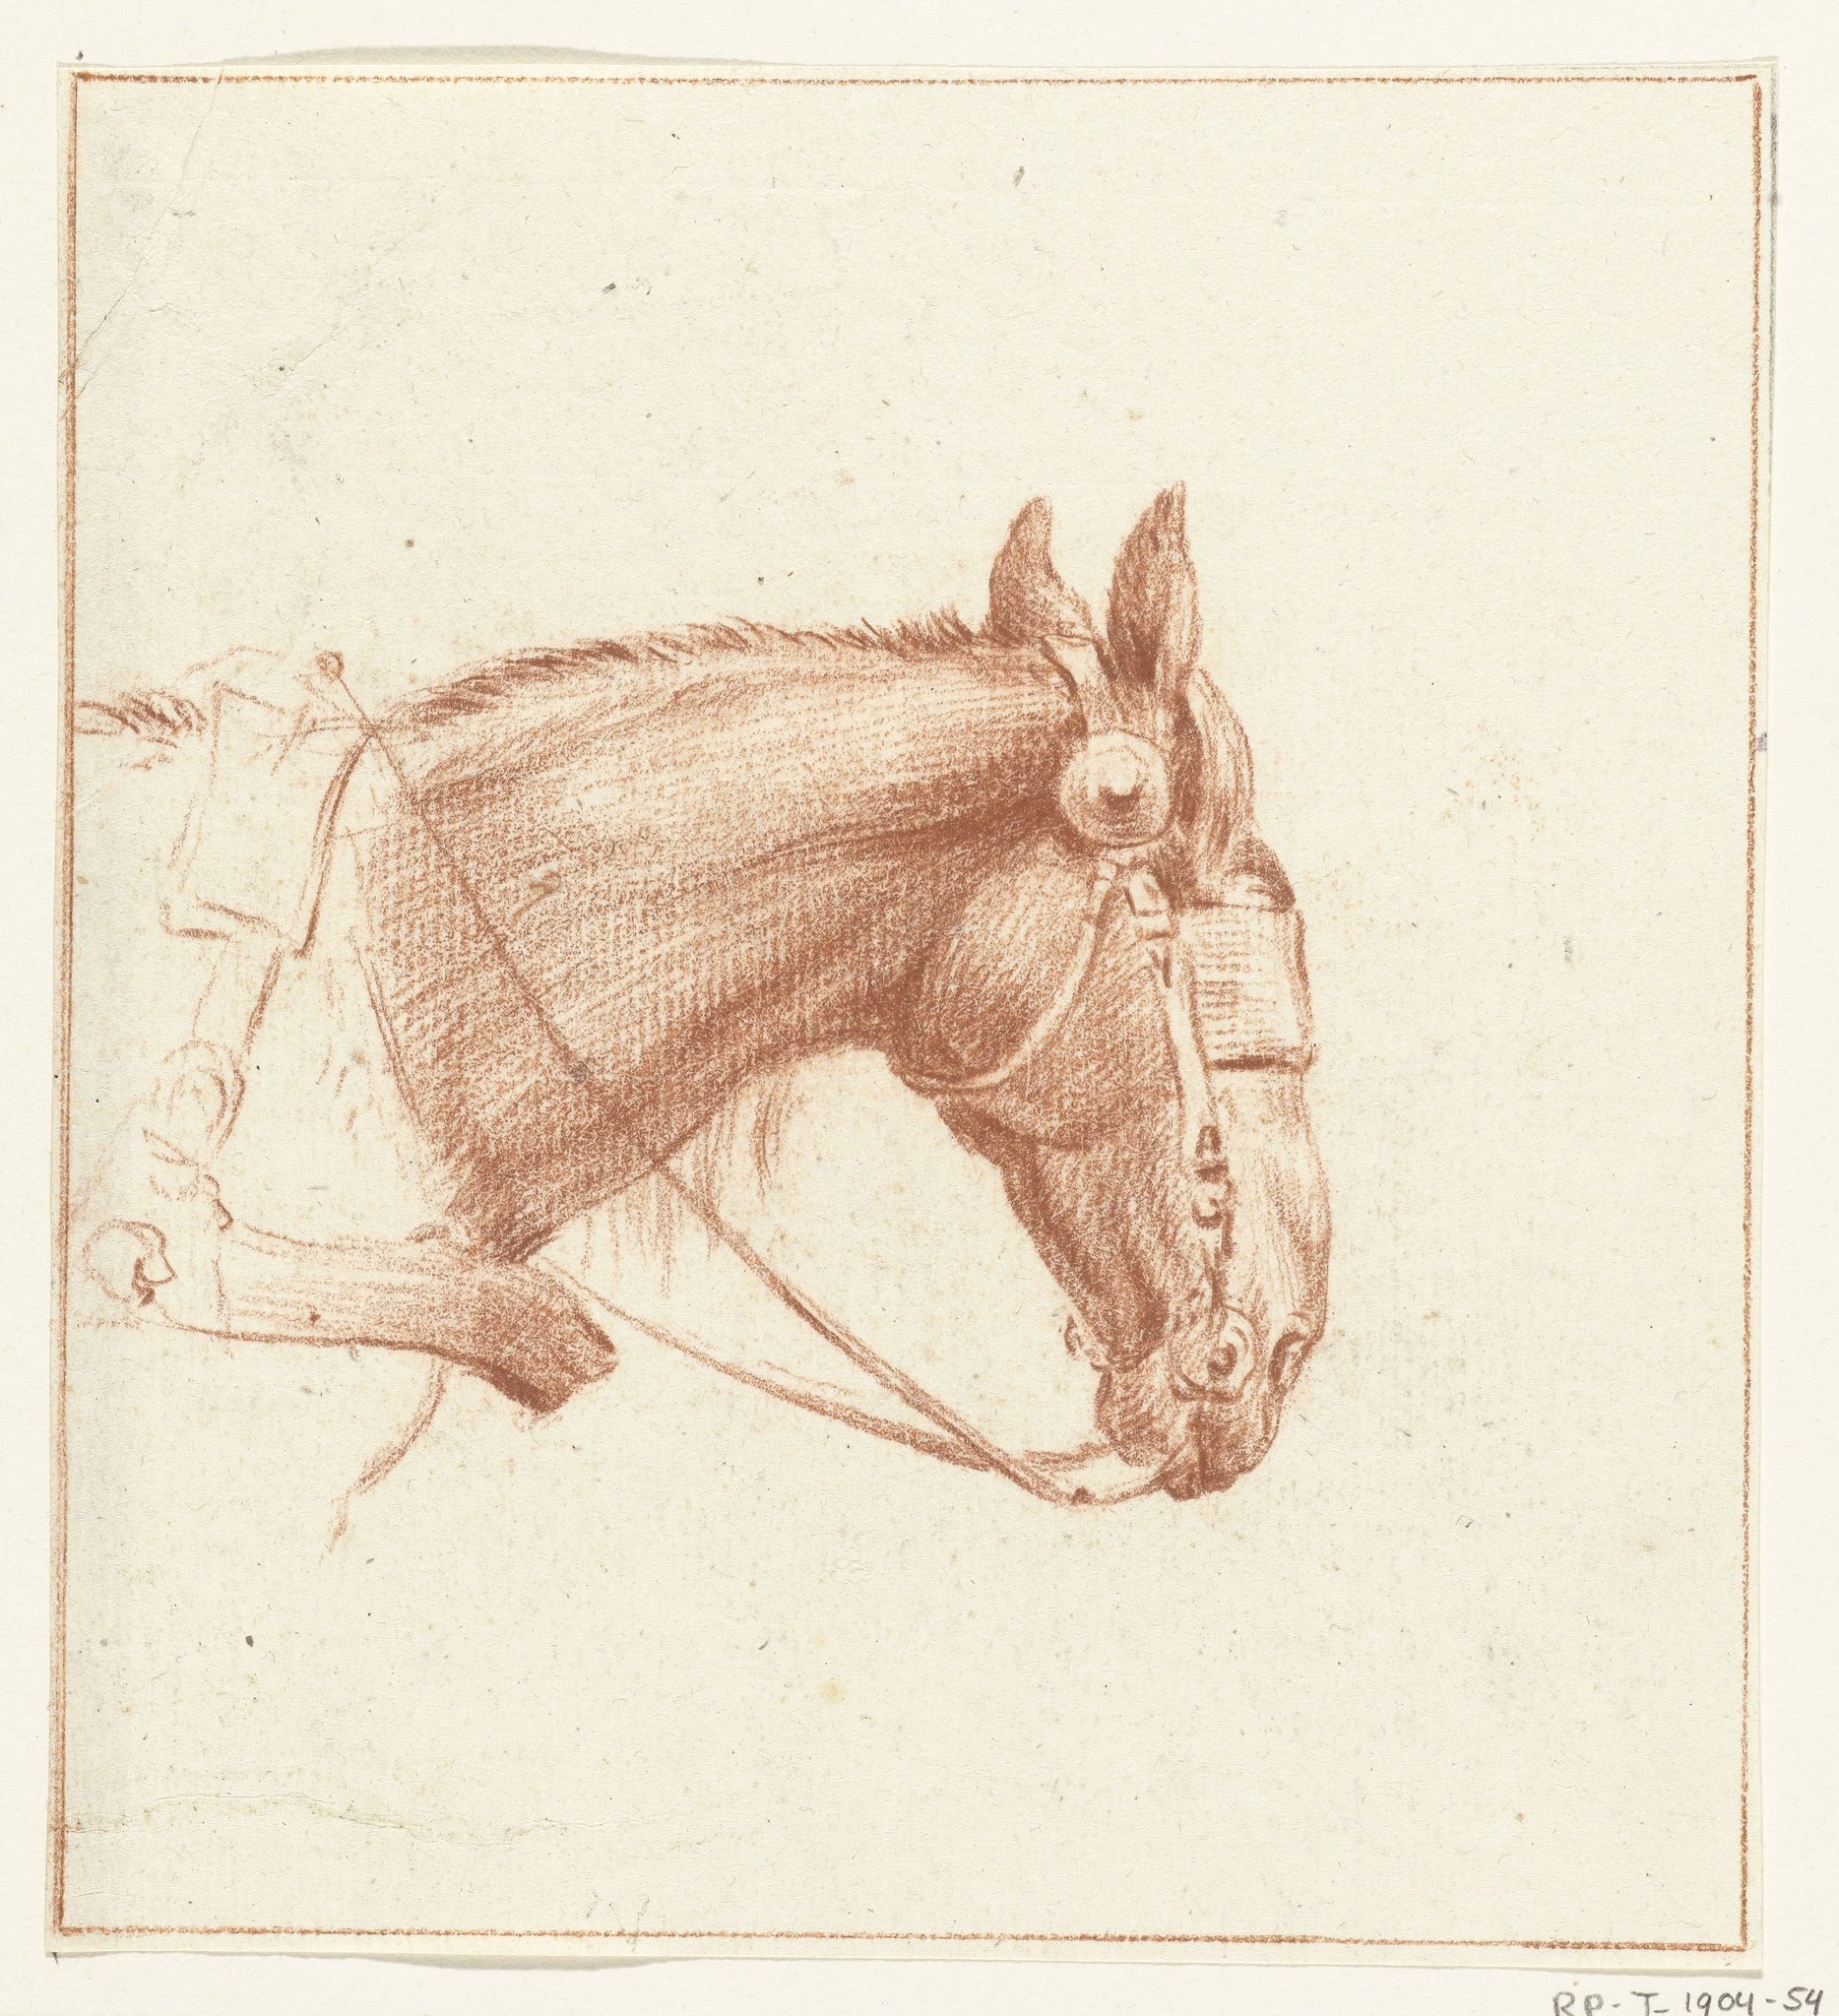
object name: drawing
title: Hoofd van een paard met oogkleppen, naar rechts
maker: jean bernard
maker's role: draughtsman, print maker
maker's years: 1765-1833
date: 1775-1833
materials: chalk, paper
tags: horse